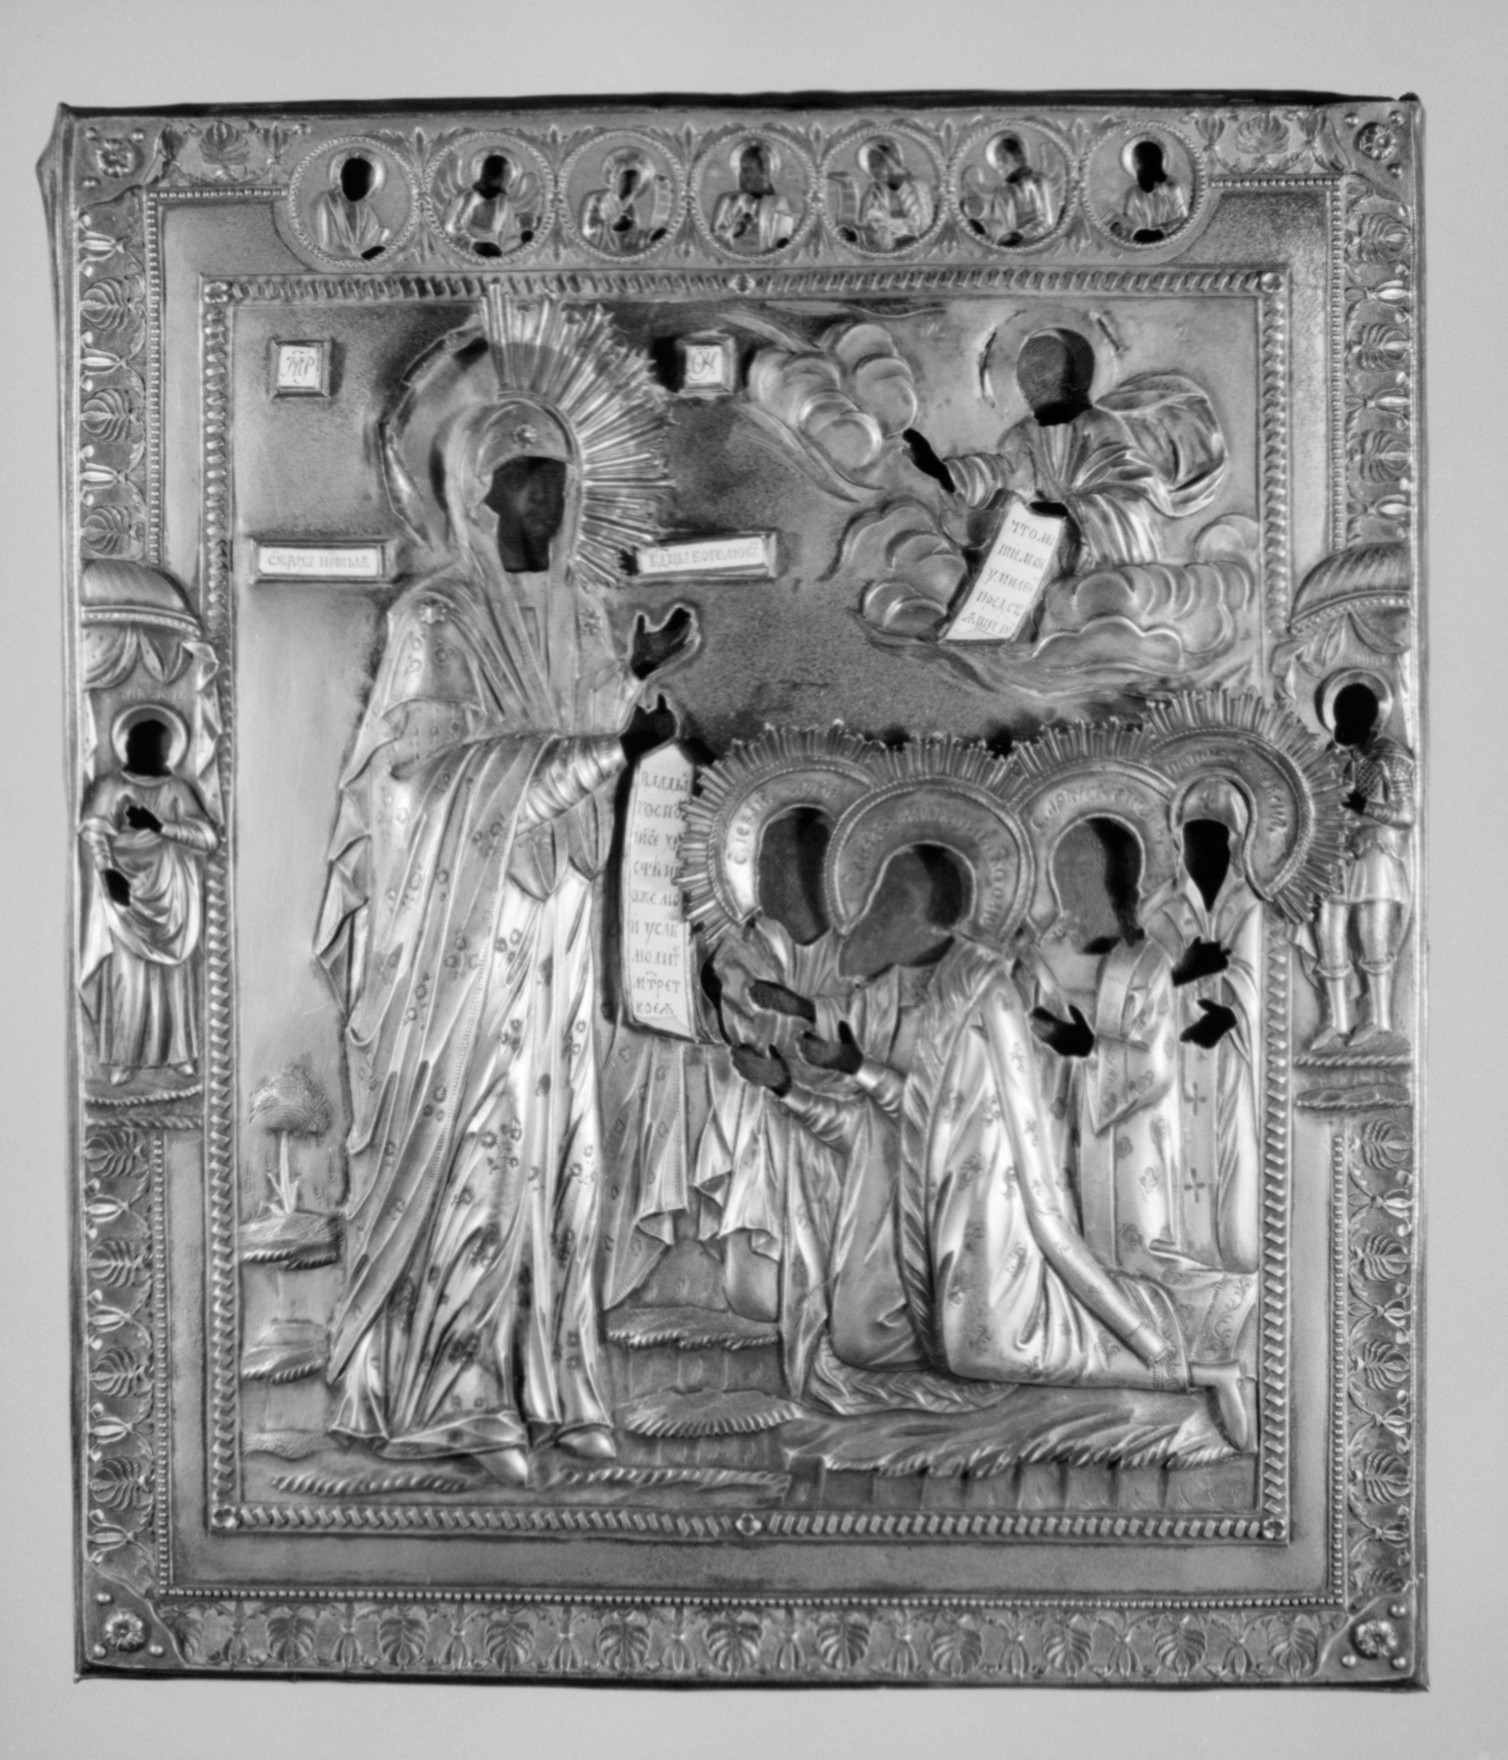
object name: icon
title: Bogoliubskaya Mother of God with the Chosen Saints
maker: unknown painter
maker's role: artist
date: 1815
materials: gesso, paint, wood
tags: goddess,saints